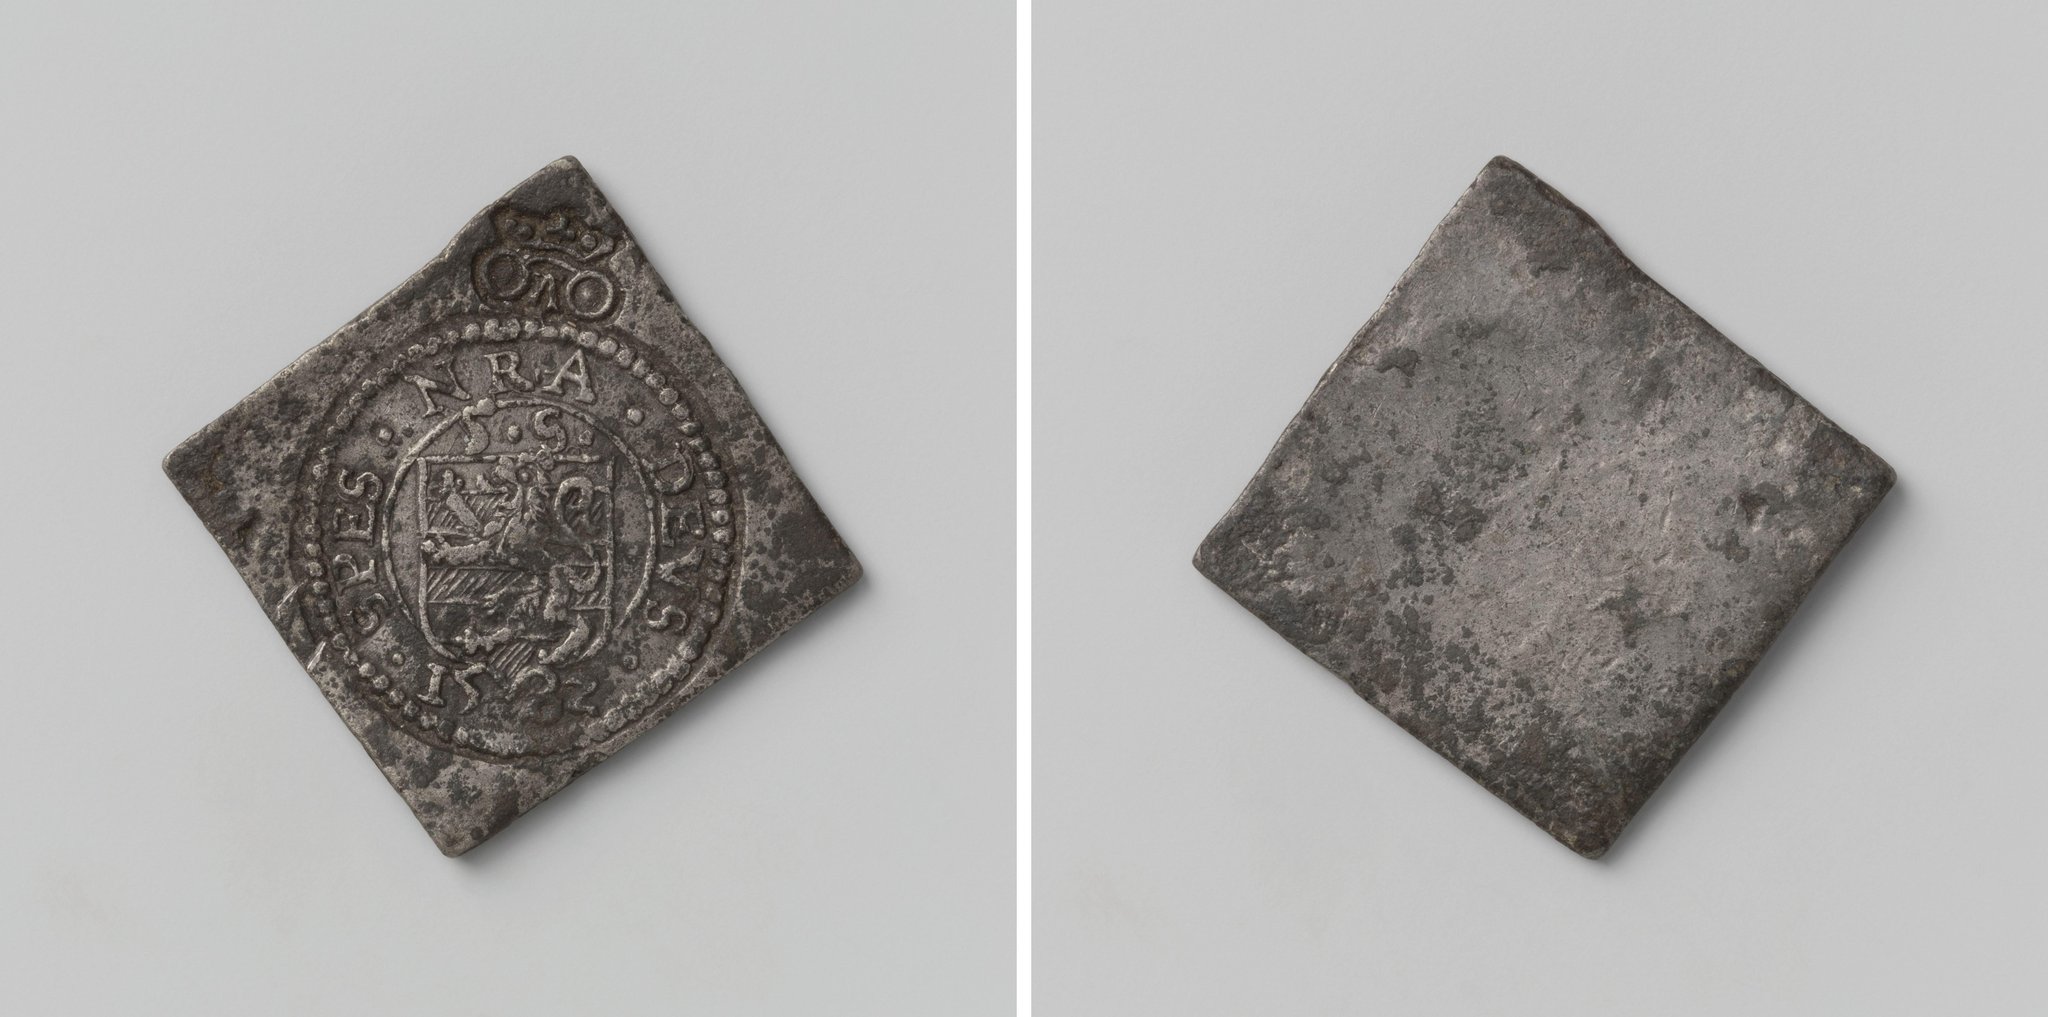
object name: coin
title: Vijf stuiver, noodmunt uit Oudenaarde, geslagen tijdens het beleg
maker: Anonymous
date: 1582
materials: tin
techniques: striking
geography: oudenaarde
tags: oudenaarde, beleg en inname van oudenaarde (1582), tachtigjarige oorlog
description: eenzijdige, ruitvormige noodmunt. Voorzijde: twee stempels: klop: stadsmerk; daaronder ronde stempel: wapenschild onder waardeaanduiding binnen omschrift. Keerzijde: blanco